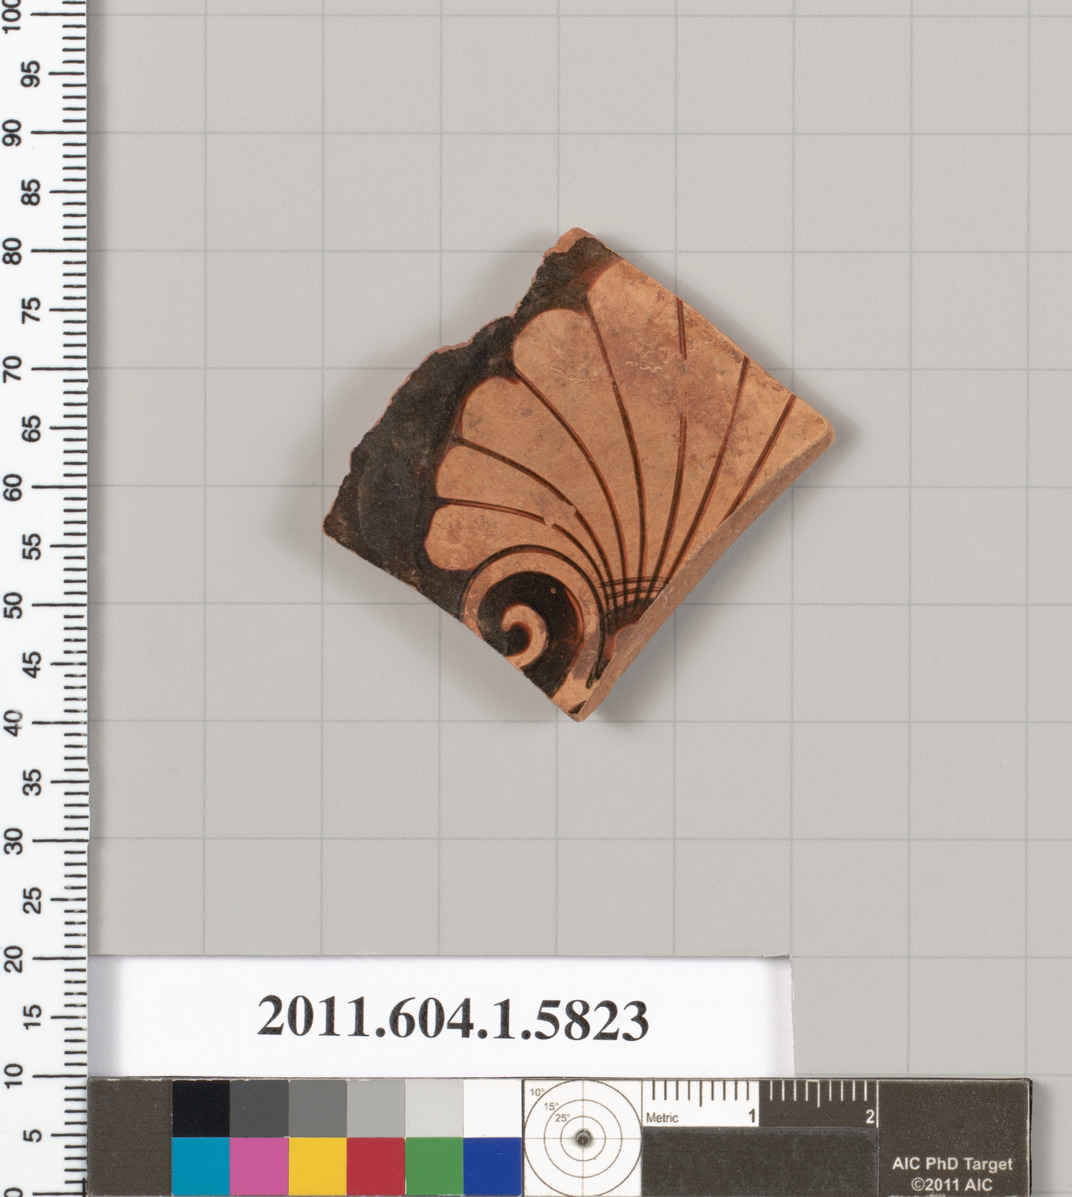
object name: kylix fragment, eye cup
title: Terracotta fragment of a kylix: eye-cup (drinking cup)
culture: greek, attic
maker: painter of the boulogne horse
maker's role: artist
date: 520-510 BCE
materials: terracotta